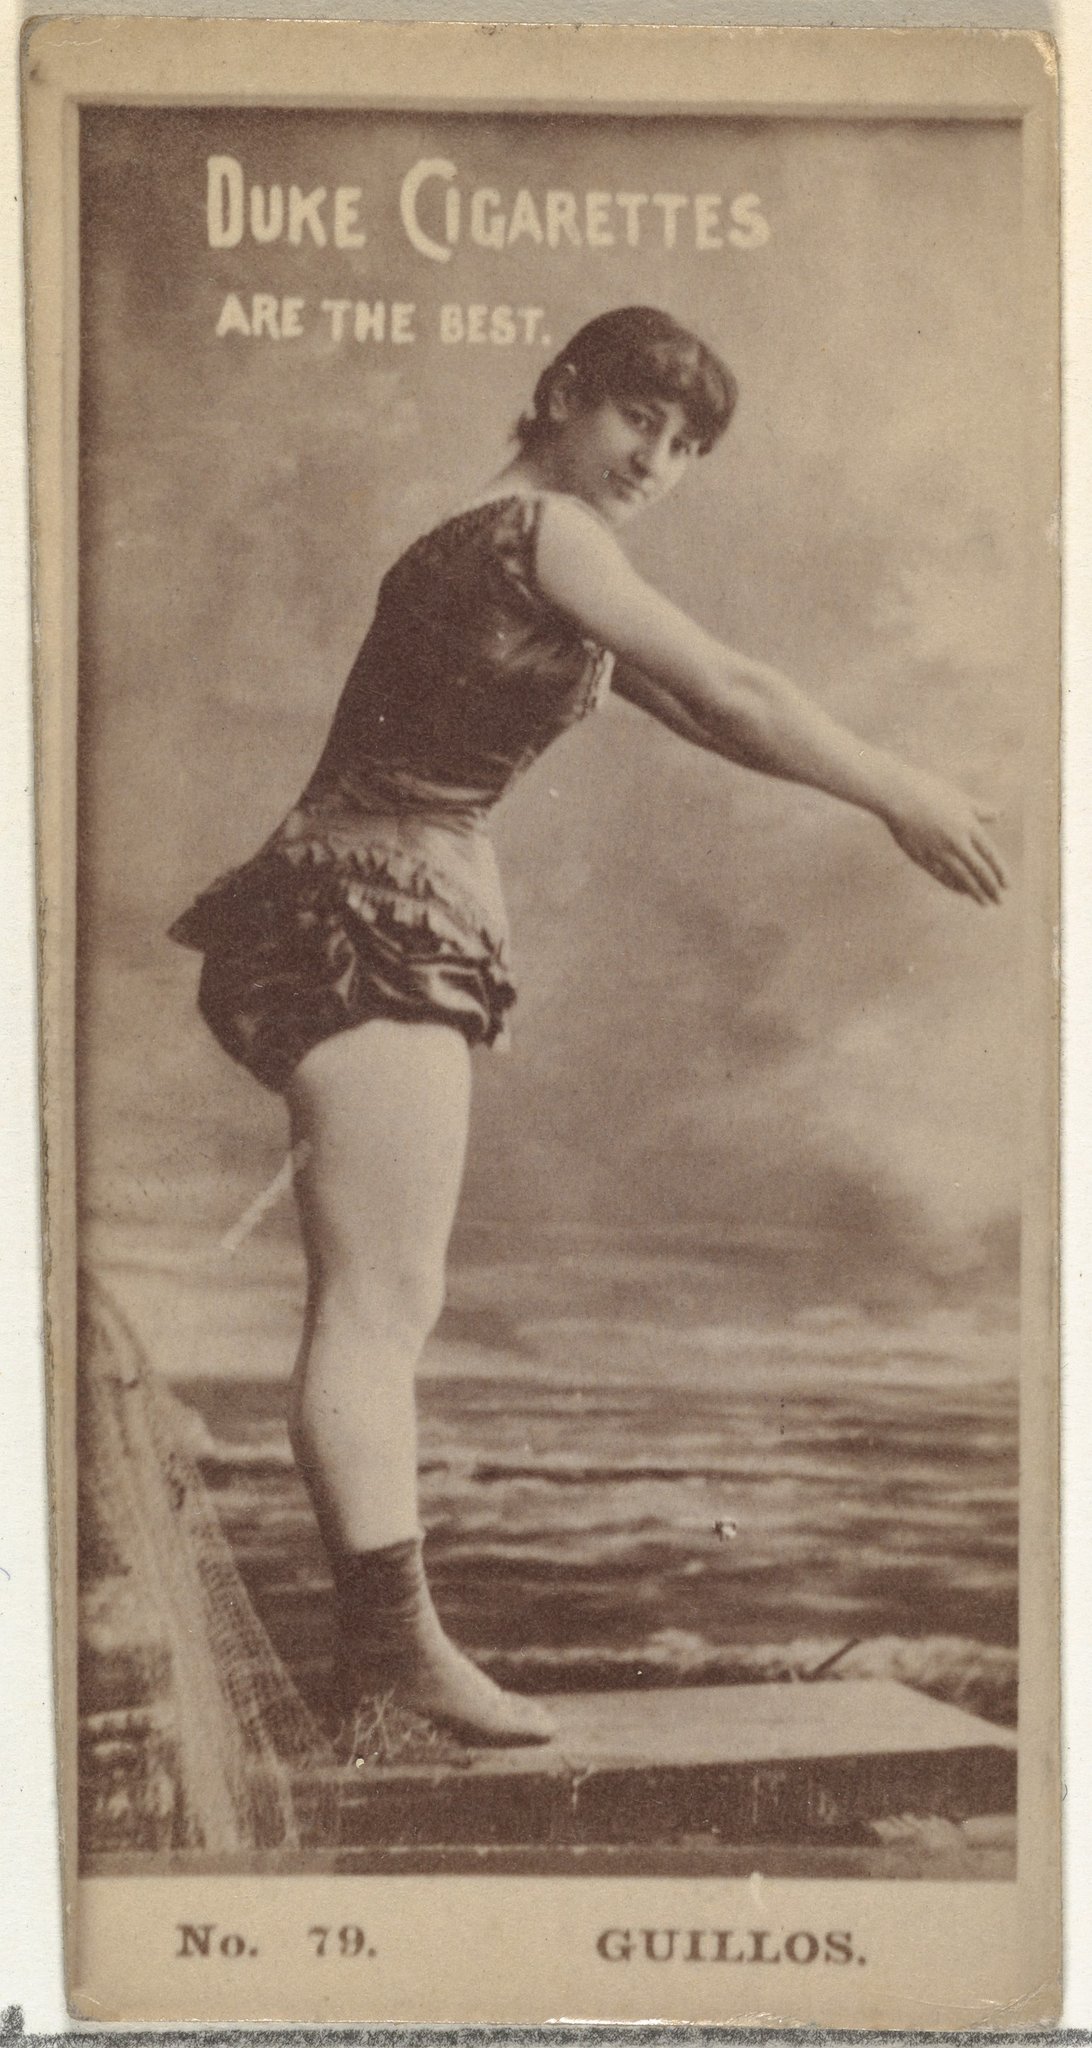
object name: photograph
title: Card Number 79, Guillos, from the Actors and Actresses series (N145-6) issued by Duke Sons & Co. to promote Duke Cigarettes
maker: w. duke, sons & co.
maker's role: publisher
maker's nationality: american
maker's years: 1870-1920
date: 1880-1889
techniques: albumen silver print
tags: portraits,women,actresses